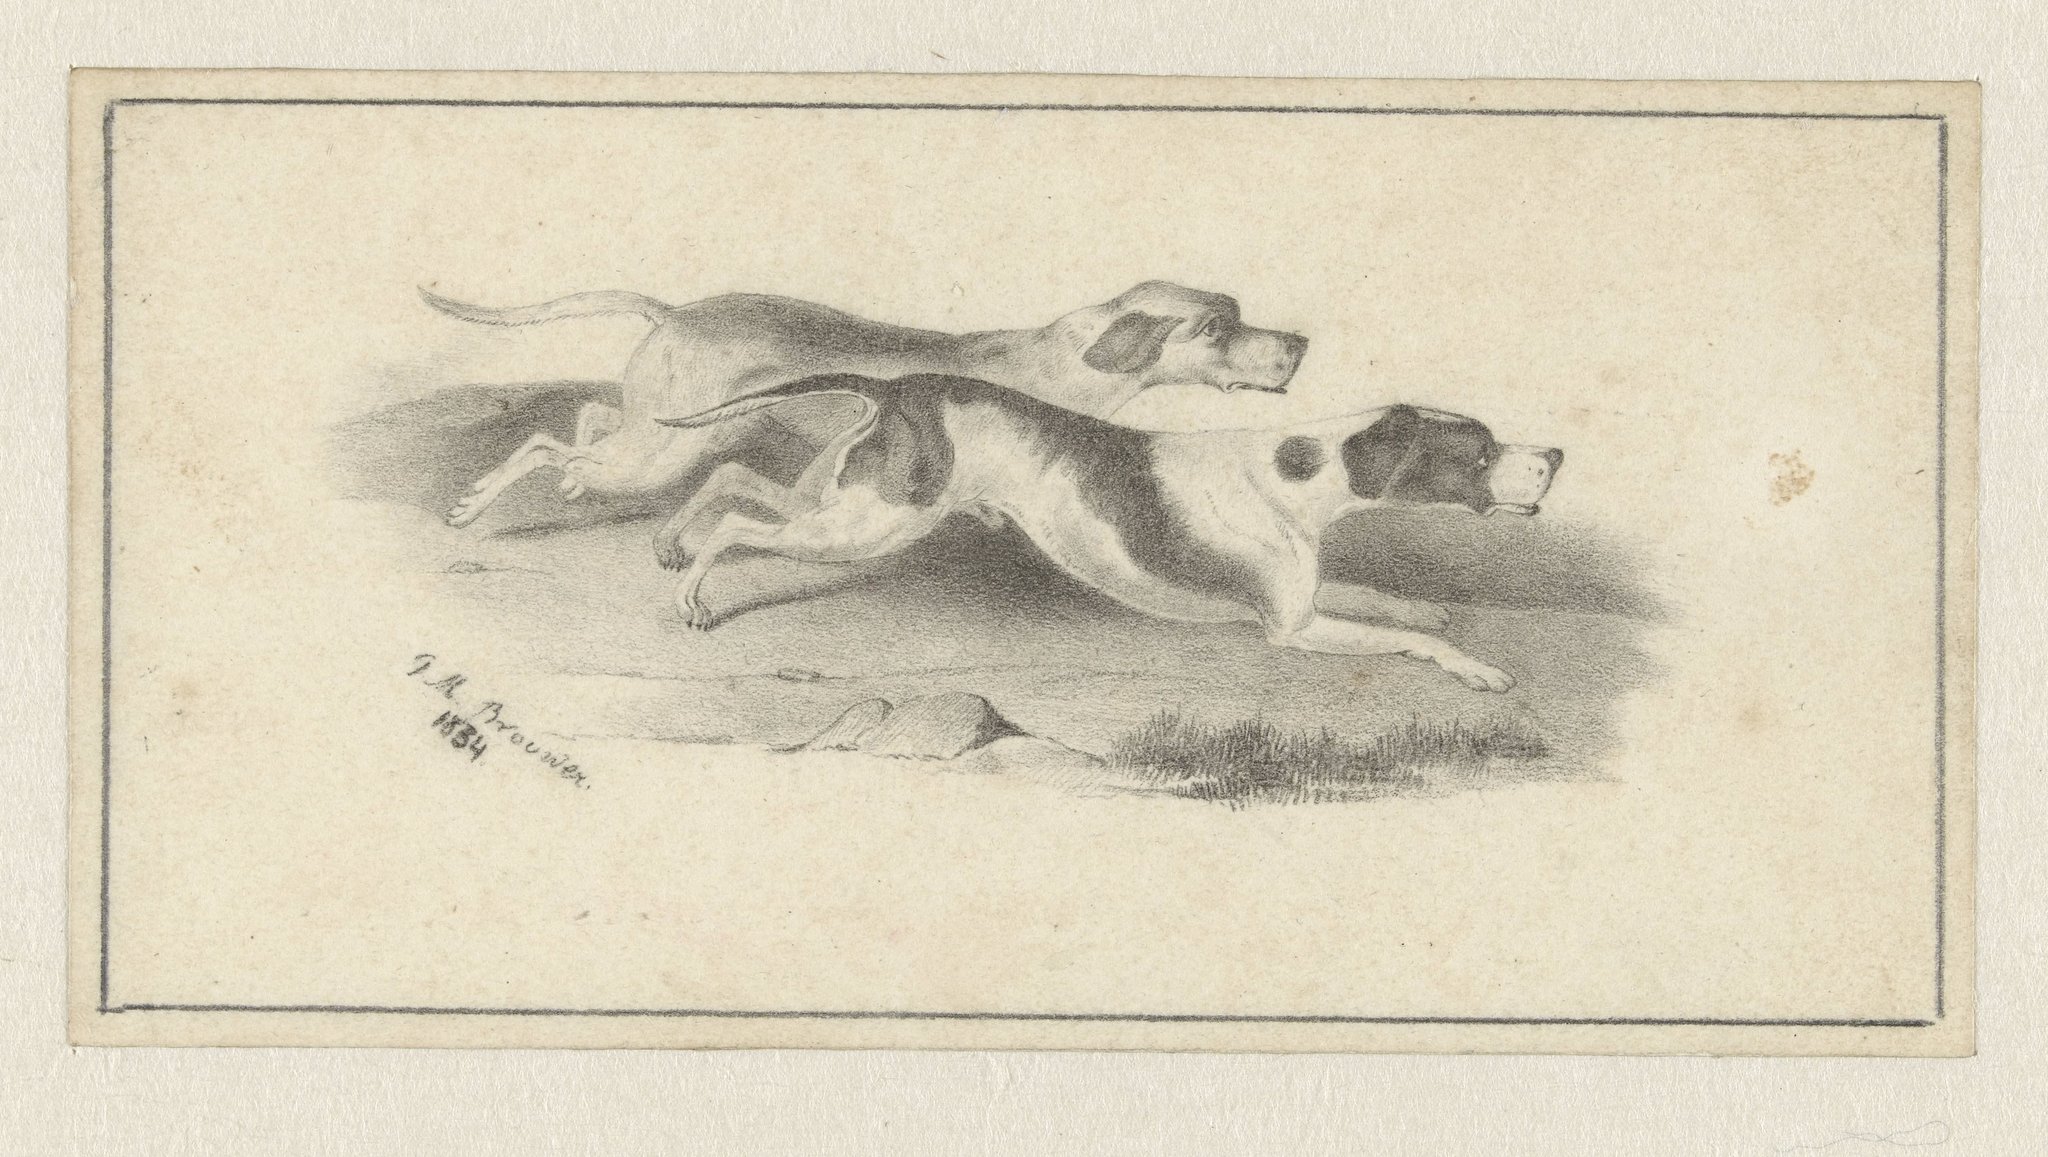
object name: drawing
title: Twee rennende jachthonden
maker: petrus marius brouwer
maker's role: draughtsman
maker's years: 1819-1886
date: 1834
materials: chalk, paper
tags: hunting dogs, dog